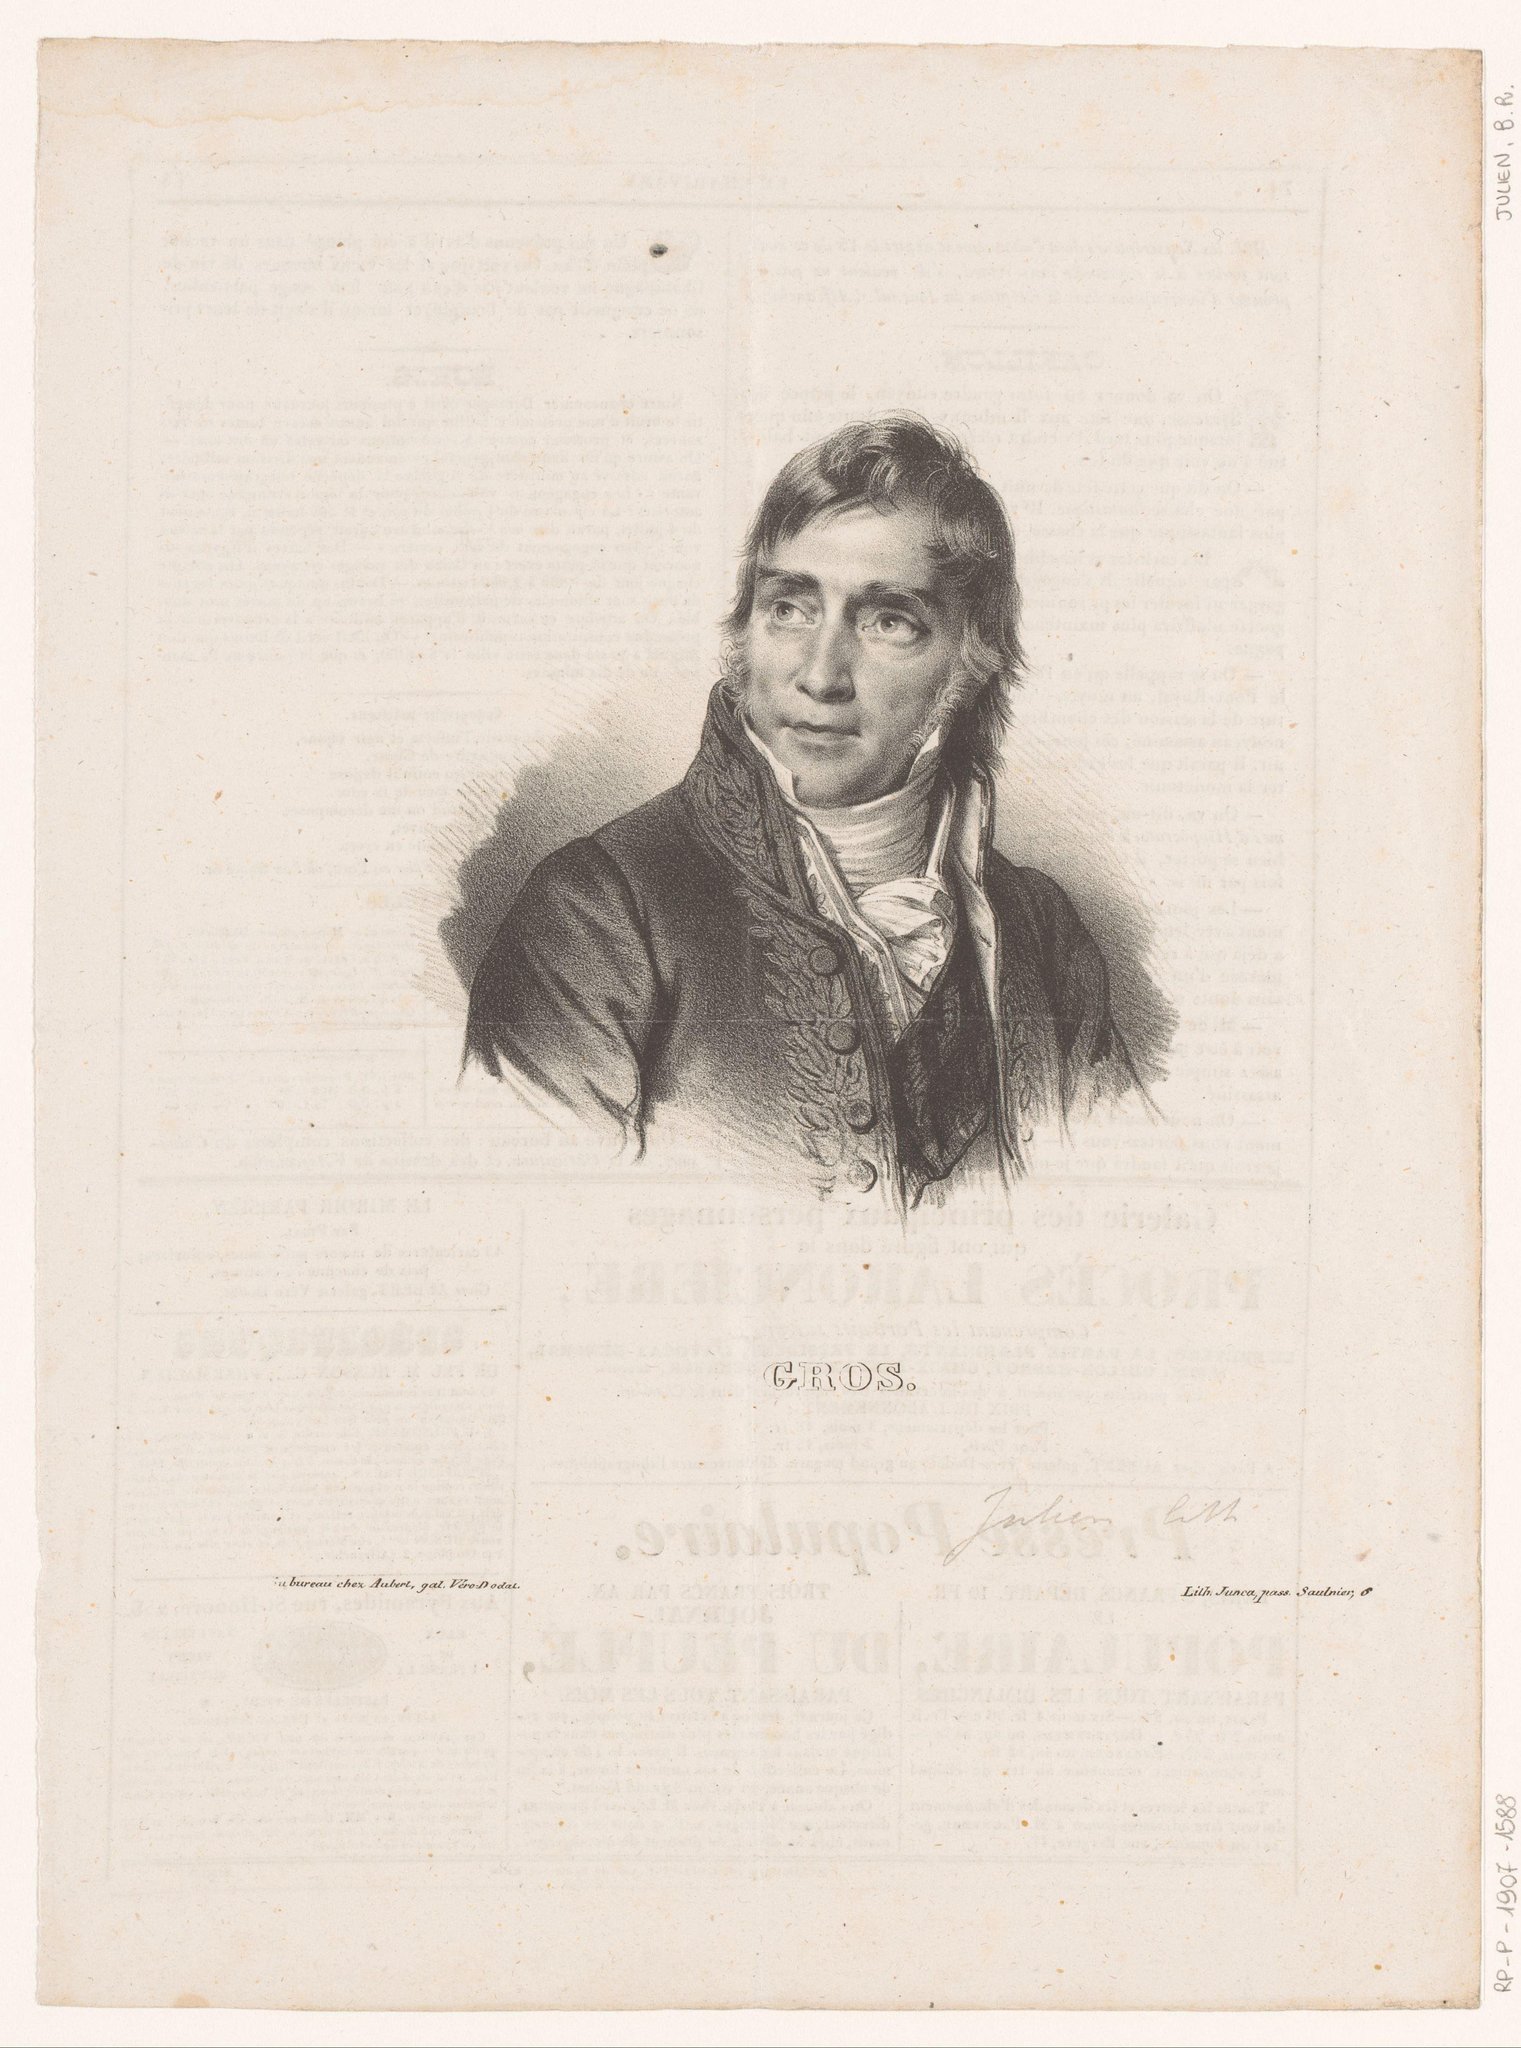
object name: print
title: Portret van Antoine-Jean Gros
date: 1835-1838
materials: paper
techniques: lithograph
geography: paris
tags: paris, painter, print maker, antoine-jean gros, historical persons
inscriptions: collector's mark: Lugt 2228a